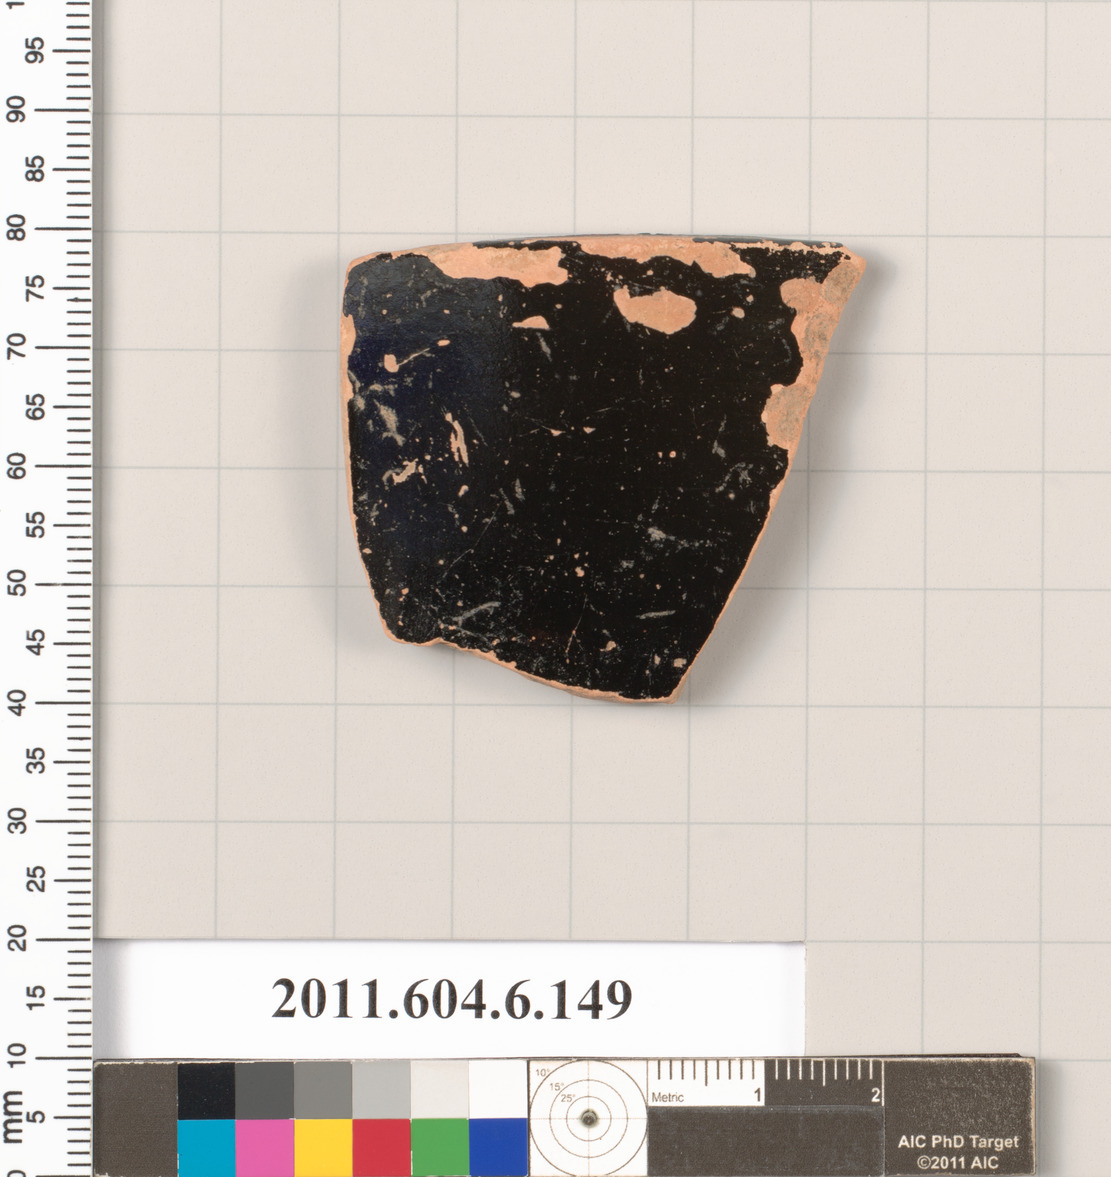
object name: undetermined open shape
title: Terracotta fragment of an open shape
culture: greek, attic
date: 600-401 BCE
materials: terracotta